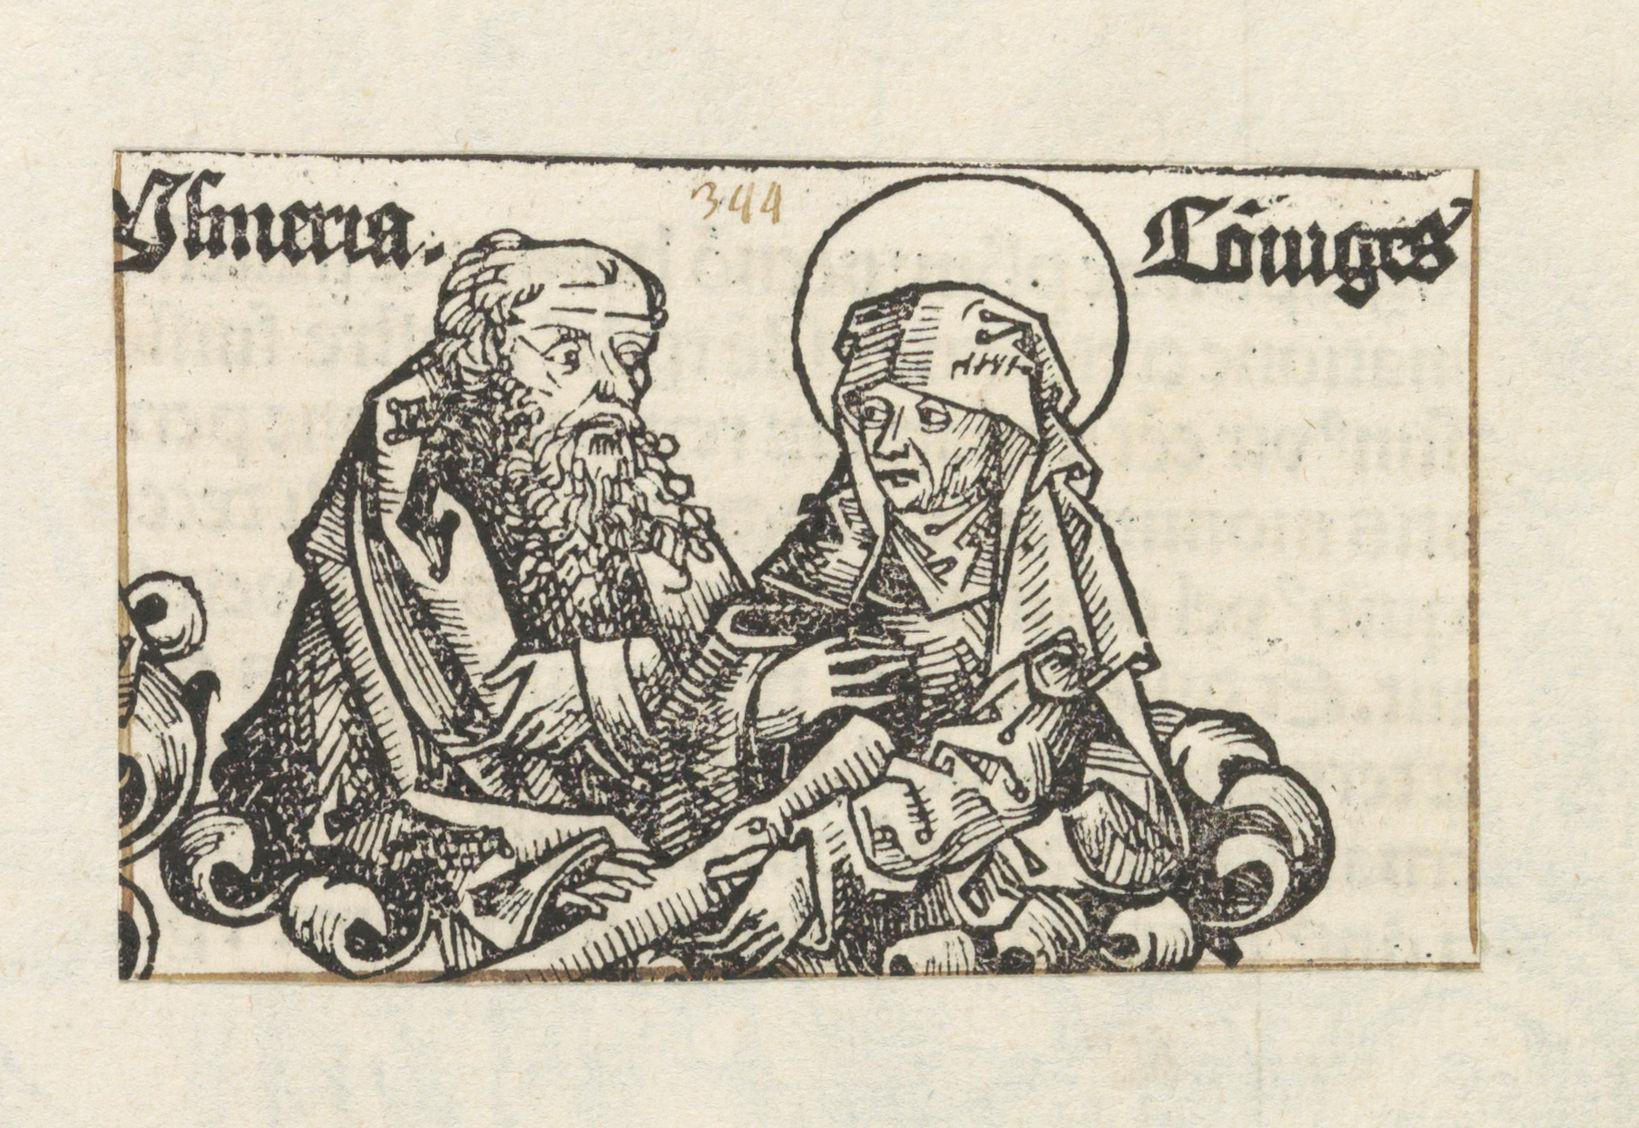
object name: print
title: Liber Chronicarum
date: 1493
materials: paper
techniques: letterpress printing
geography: nuremberg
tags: persons from the old testament (not in biblical context, nor occurring in legendary/historical extensions included in division 71)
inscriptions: inscription: ‘344’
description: Een bloemkelk met een bebaarde man en vrouw met halo. De voorstelling is onderdeel van de stamboom van Johannes de Doper in de Liber Chronicarum. De tekst identificeert de vrouw als Ismeria, de zus van Maria's moeder, de heilige Anna. De prent maakt deel uit van een album.